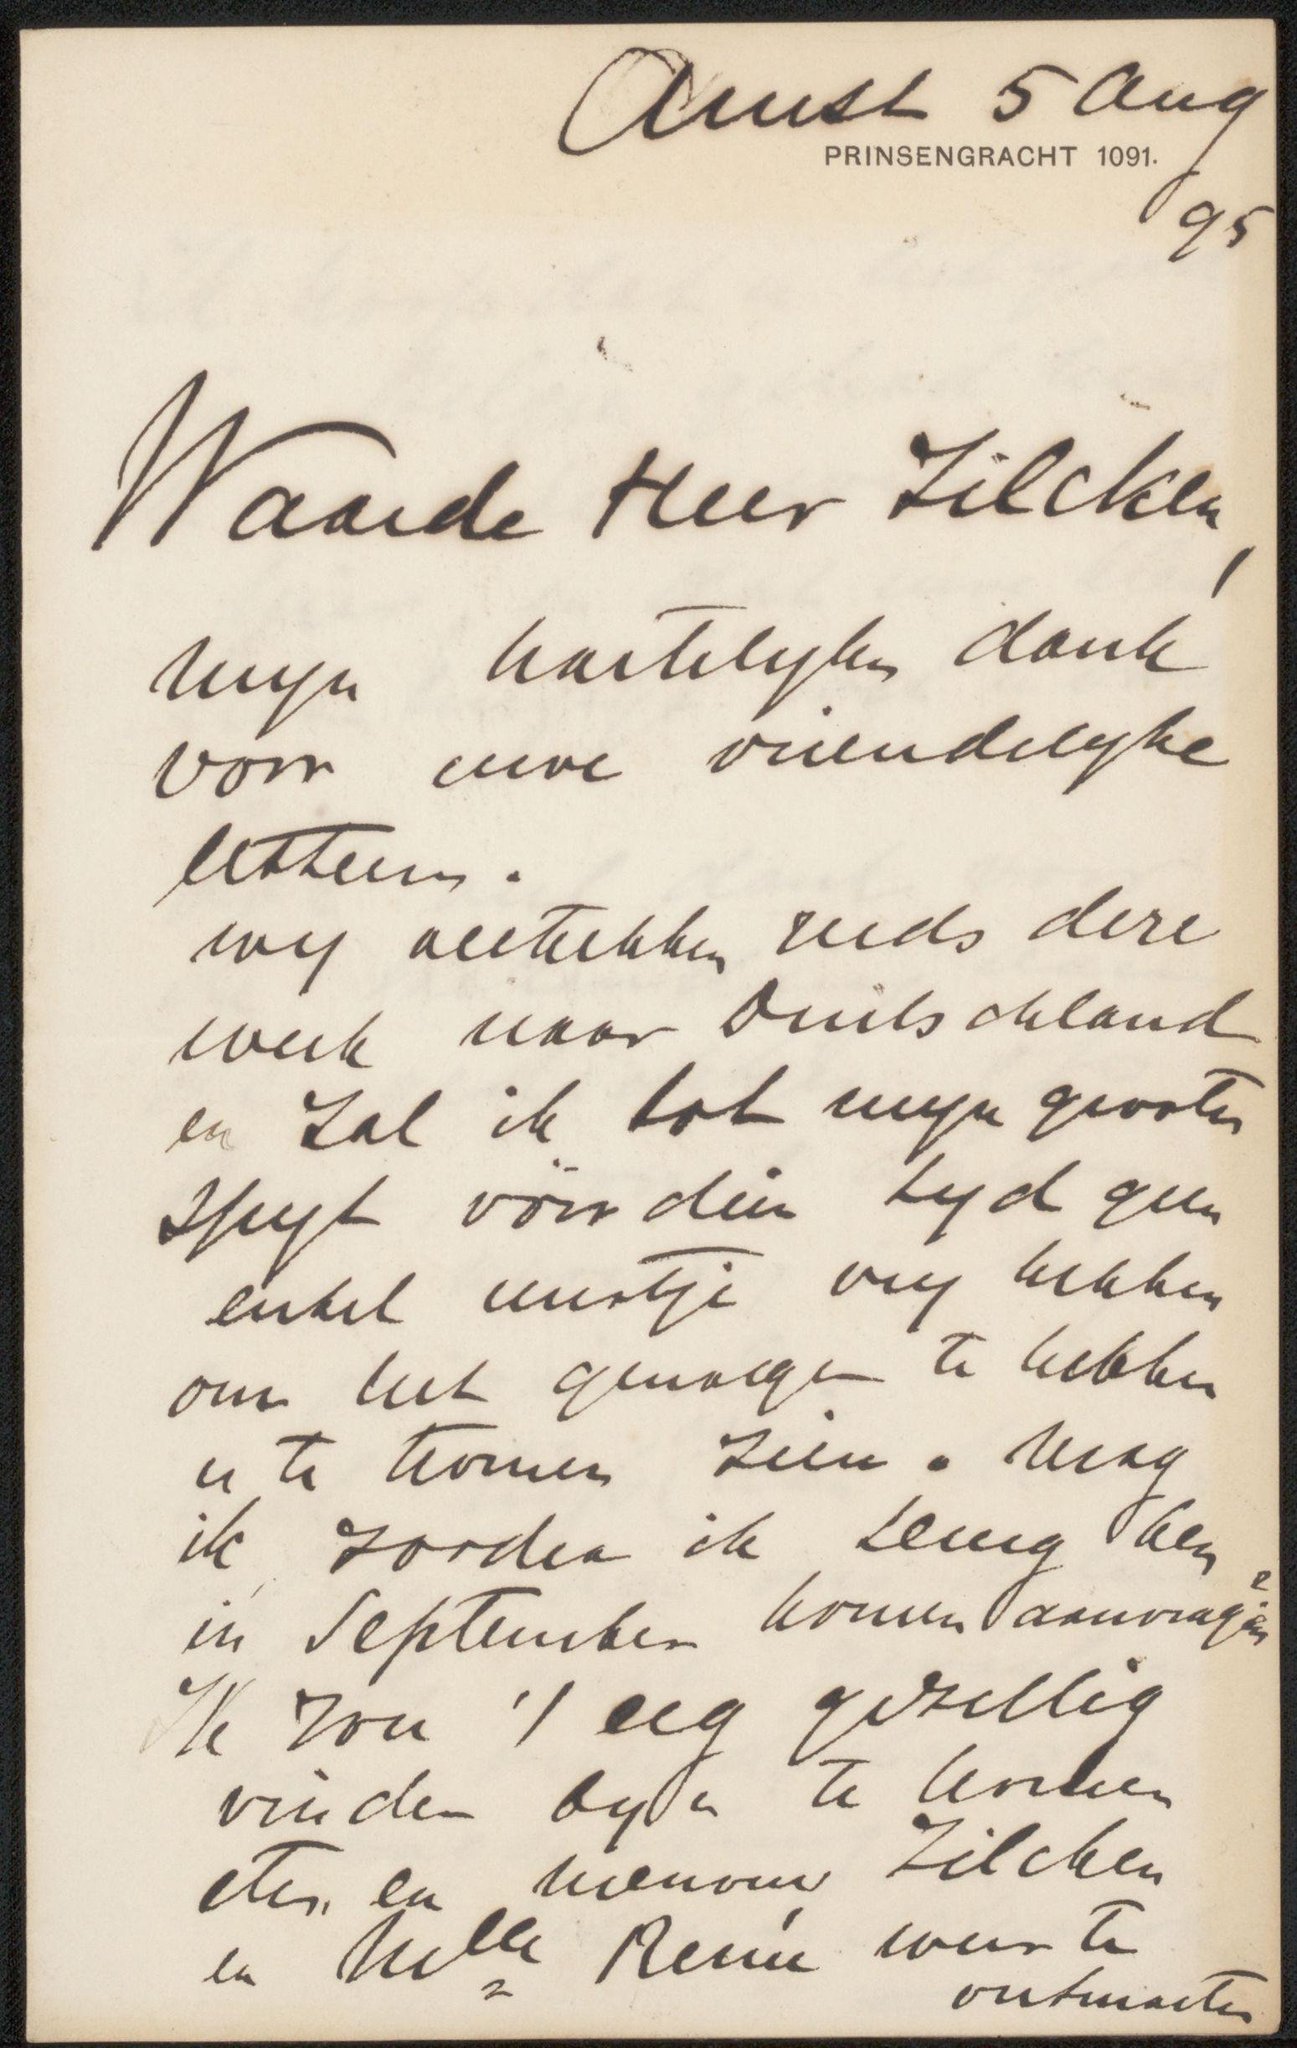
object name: letter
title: Brief aan Philip Zilcken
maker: thérèse schwartze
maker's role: draughtsman, painter, print maker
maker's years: 1851-1918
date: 1895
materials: ink, paper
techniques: pen, printing, writing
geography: amsterdam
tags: the hague, philip zilcken, germany, belgium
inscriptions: collector's mark: ‘RPK’, watermark